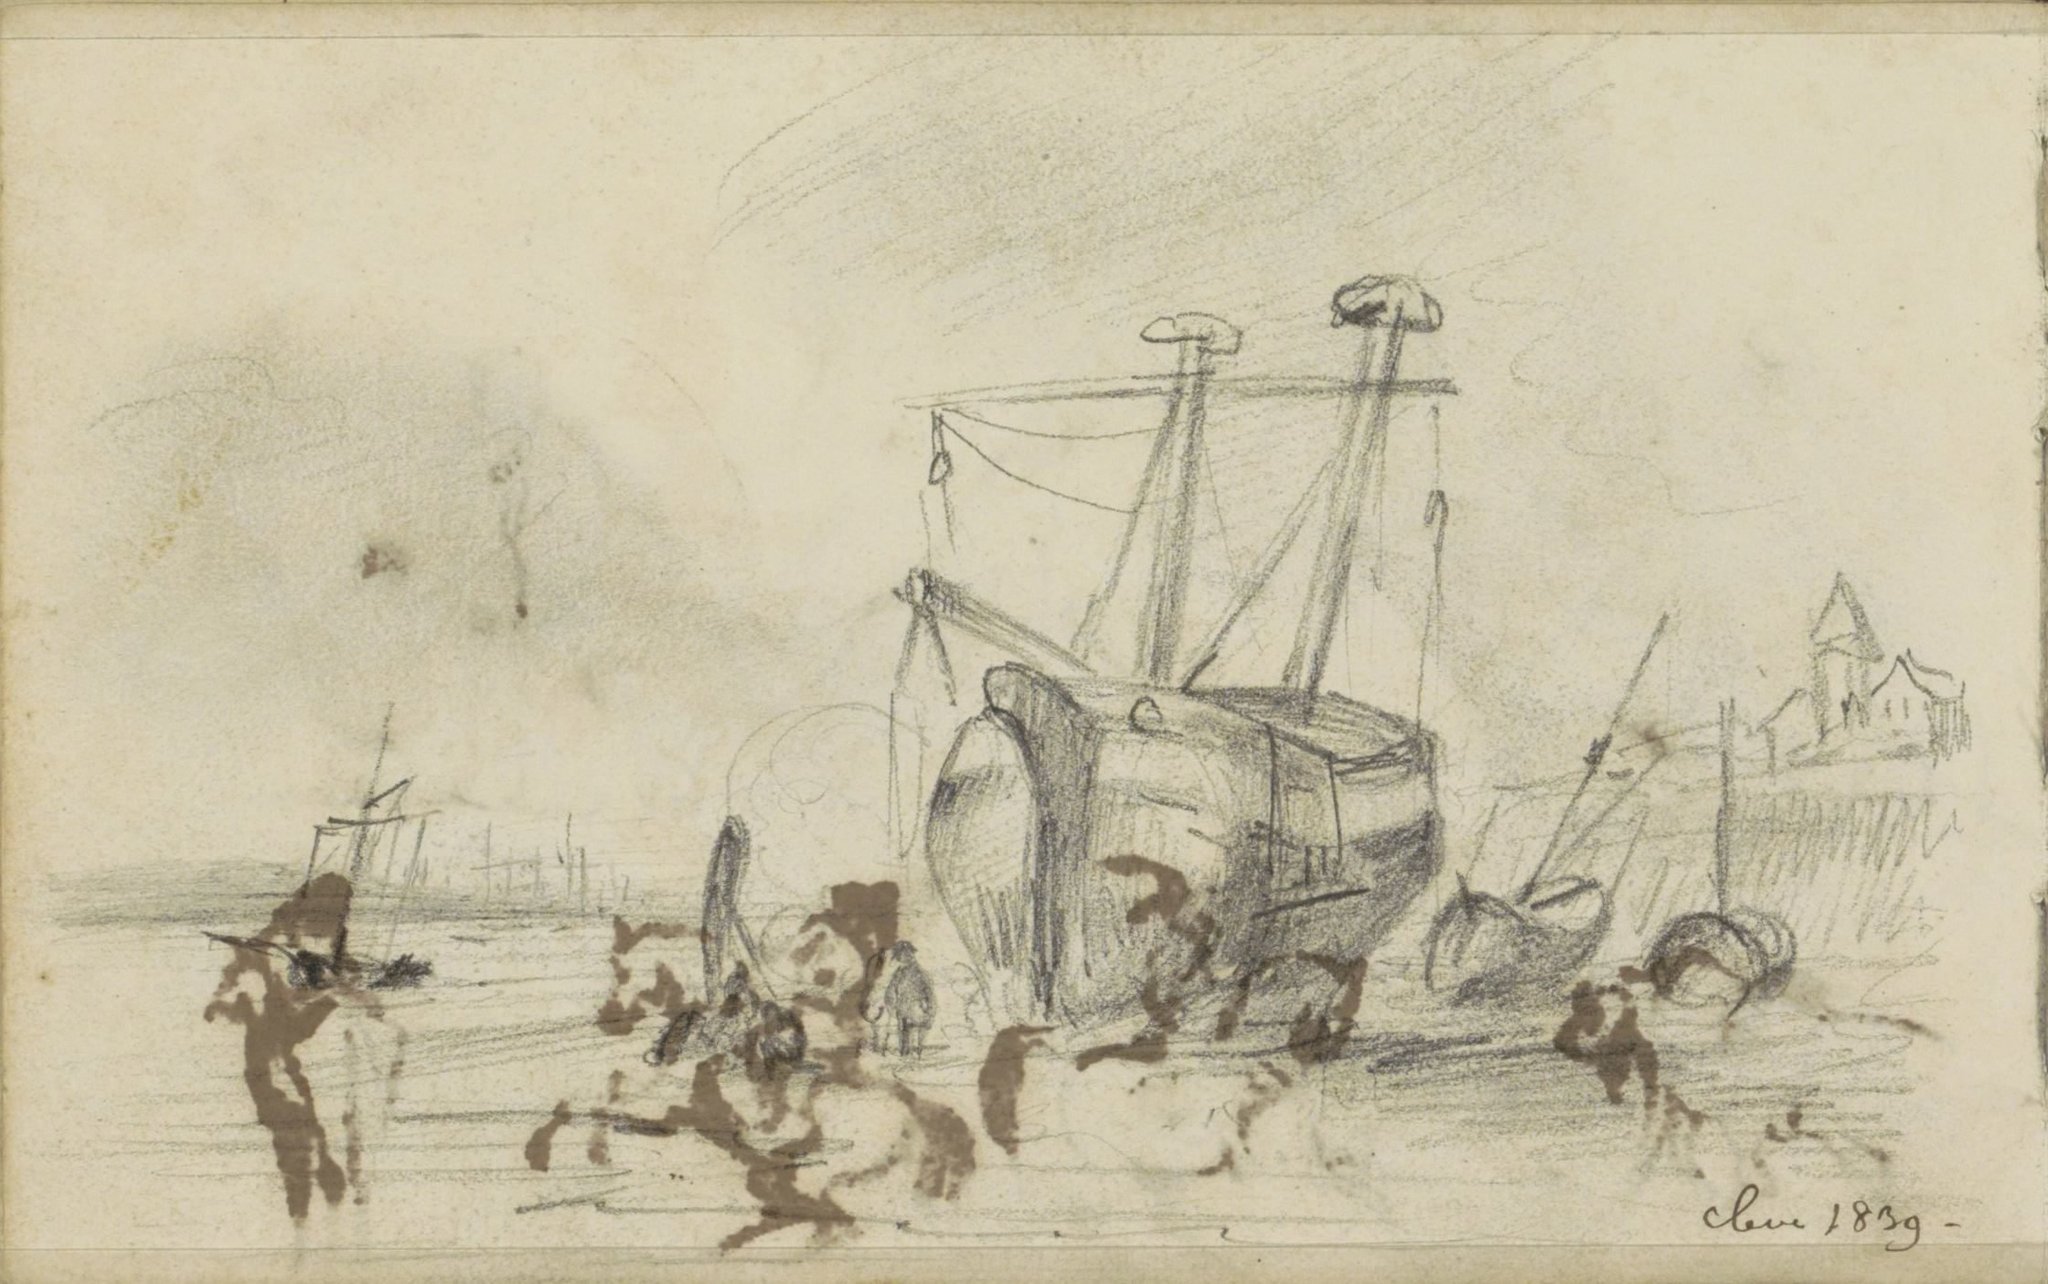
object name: sketchbook leaf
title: Zeilschepen bij een aanlegplaats in Kleef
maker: johannes tavenraat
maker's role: draughtsman, painter, print maker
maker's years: 1809-1881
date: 1839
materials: paper, pencil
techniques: pen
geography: cleves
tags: sailing-ship, sailing-boat, street (+ city(-scape) with figures, staffage)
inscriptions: date and inscription: ‘Cleve 1839.’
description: Vermoedelijk aan de Rijn. Op de voorgrond ook enkele figuren bij het schip. Blad 29 verso uit een schetsboek met 37 bladen.